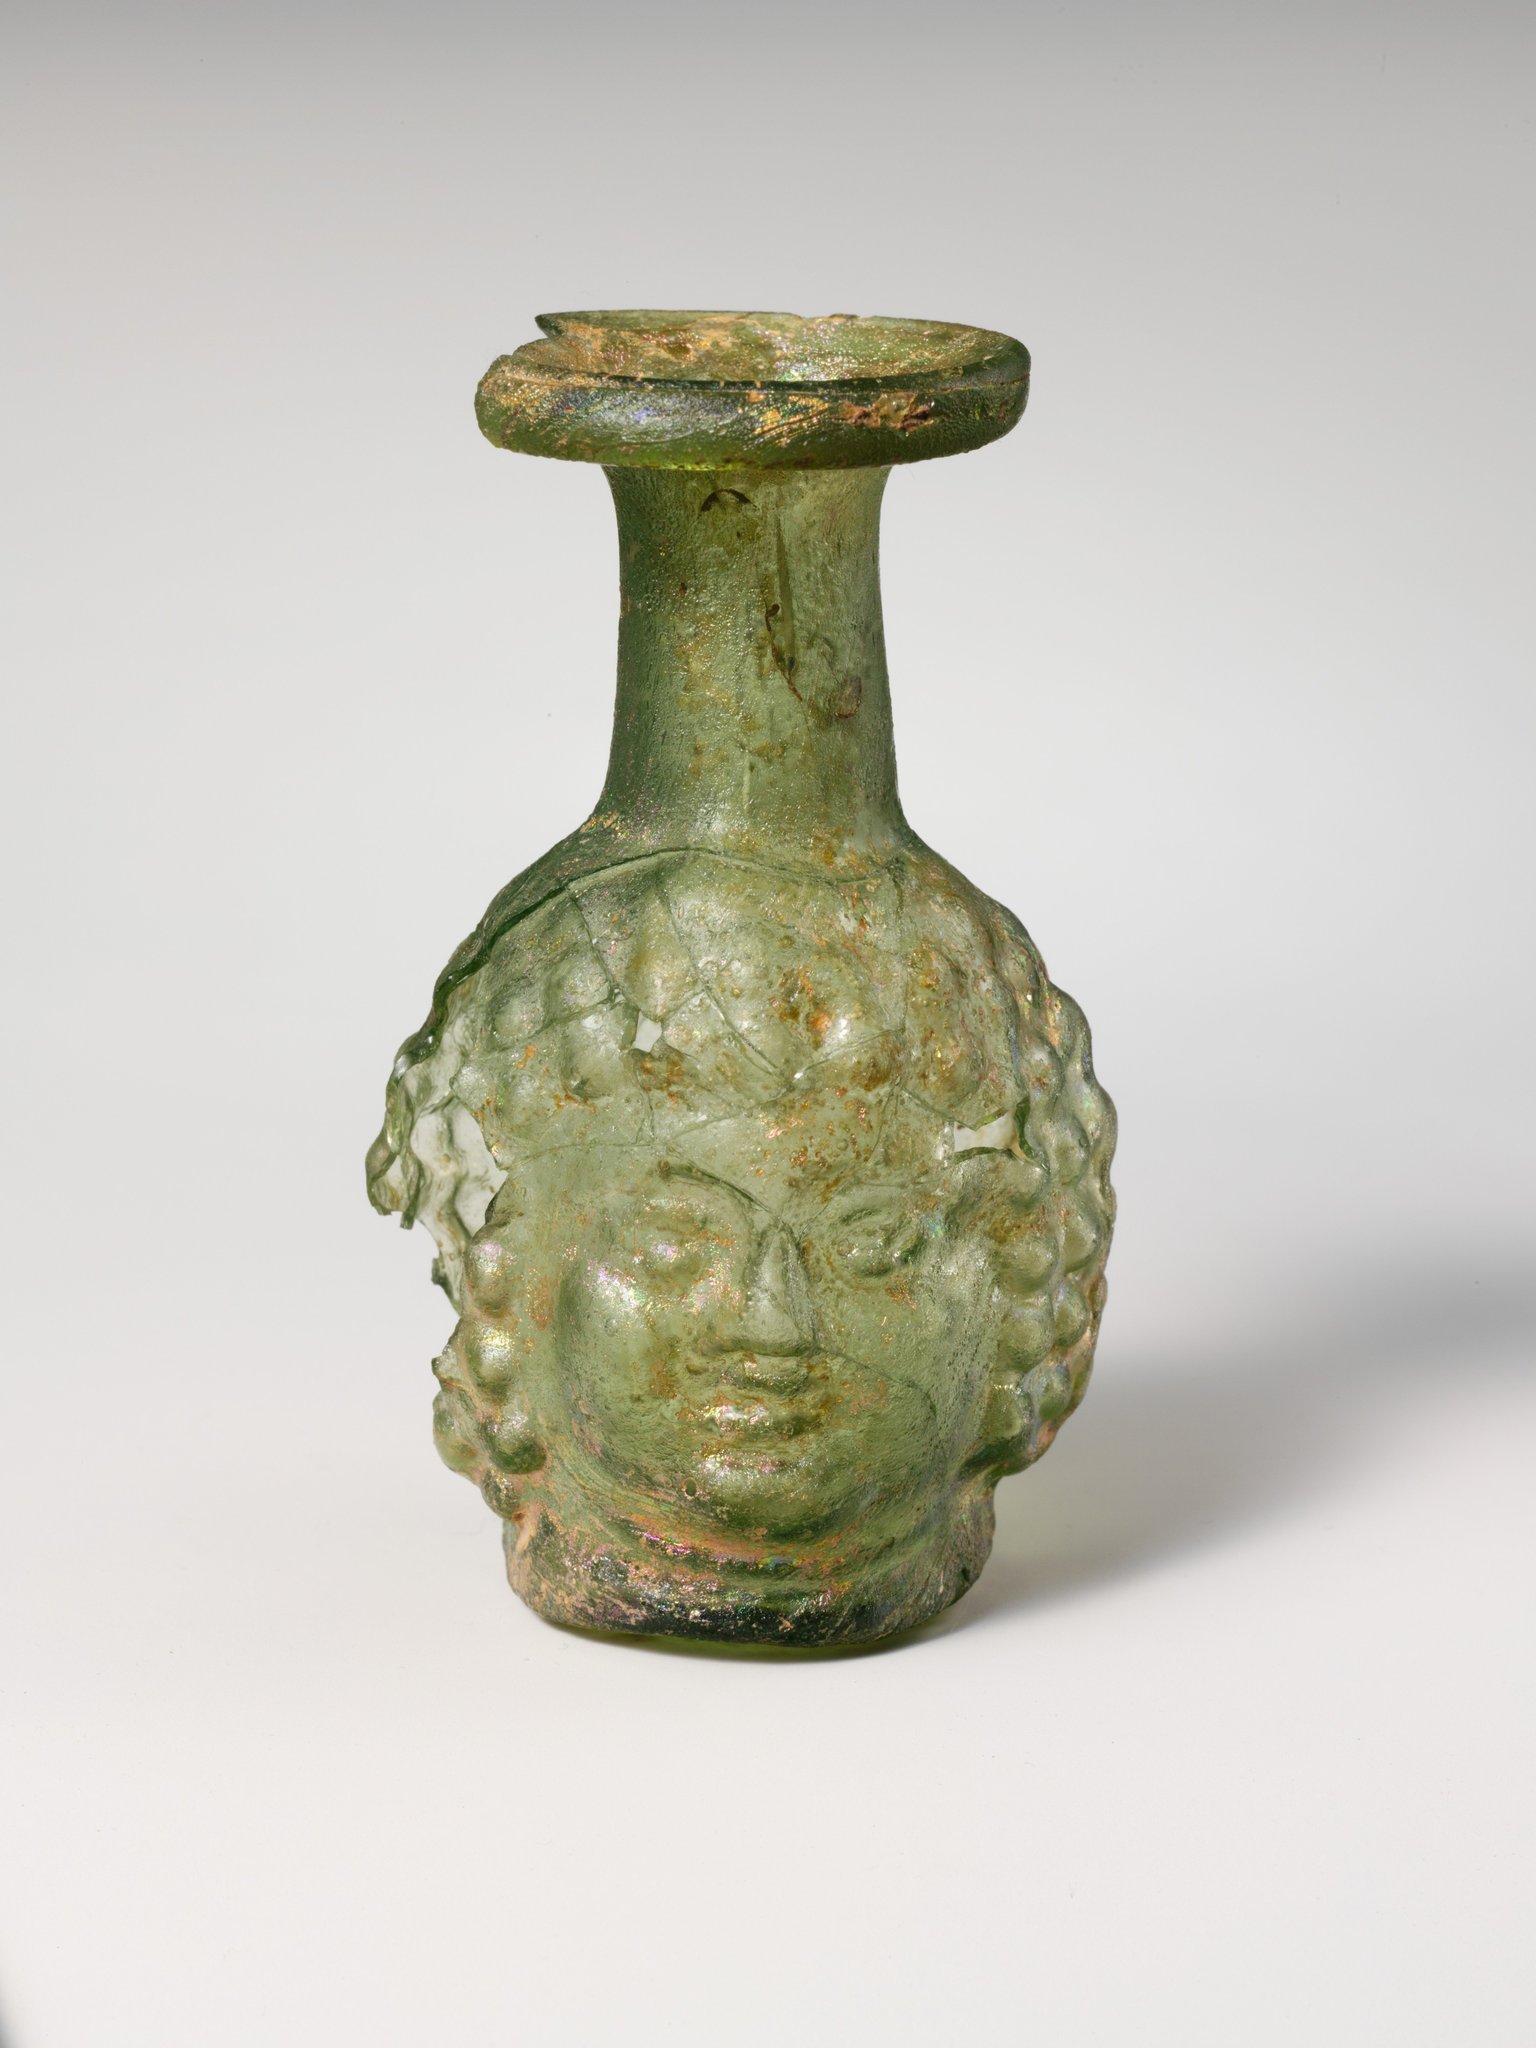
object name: flask, double head shaped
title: Glass double head flask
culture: roman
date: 201-400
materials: glass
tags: heads